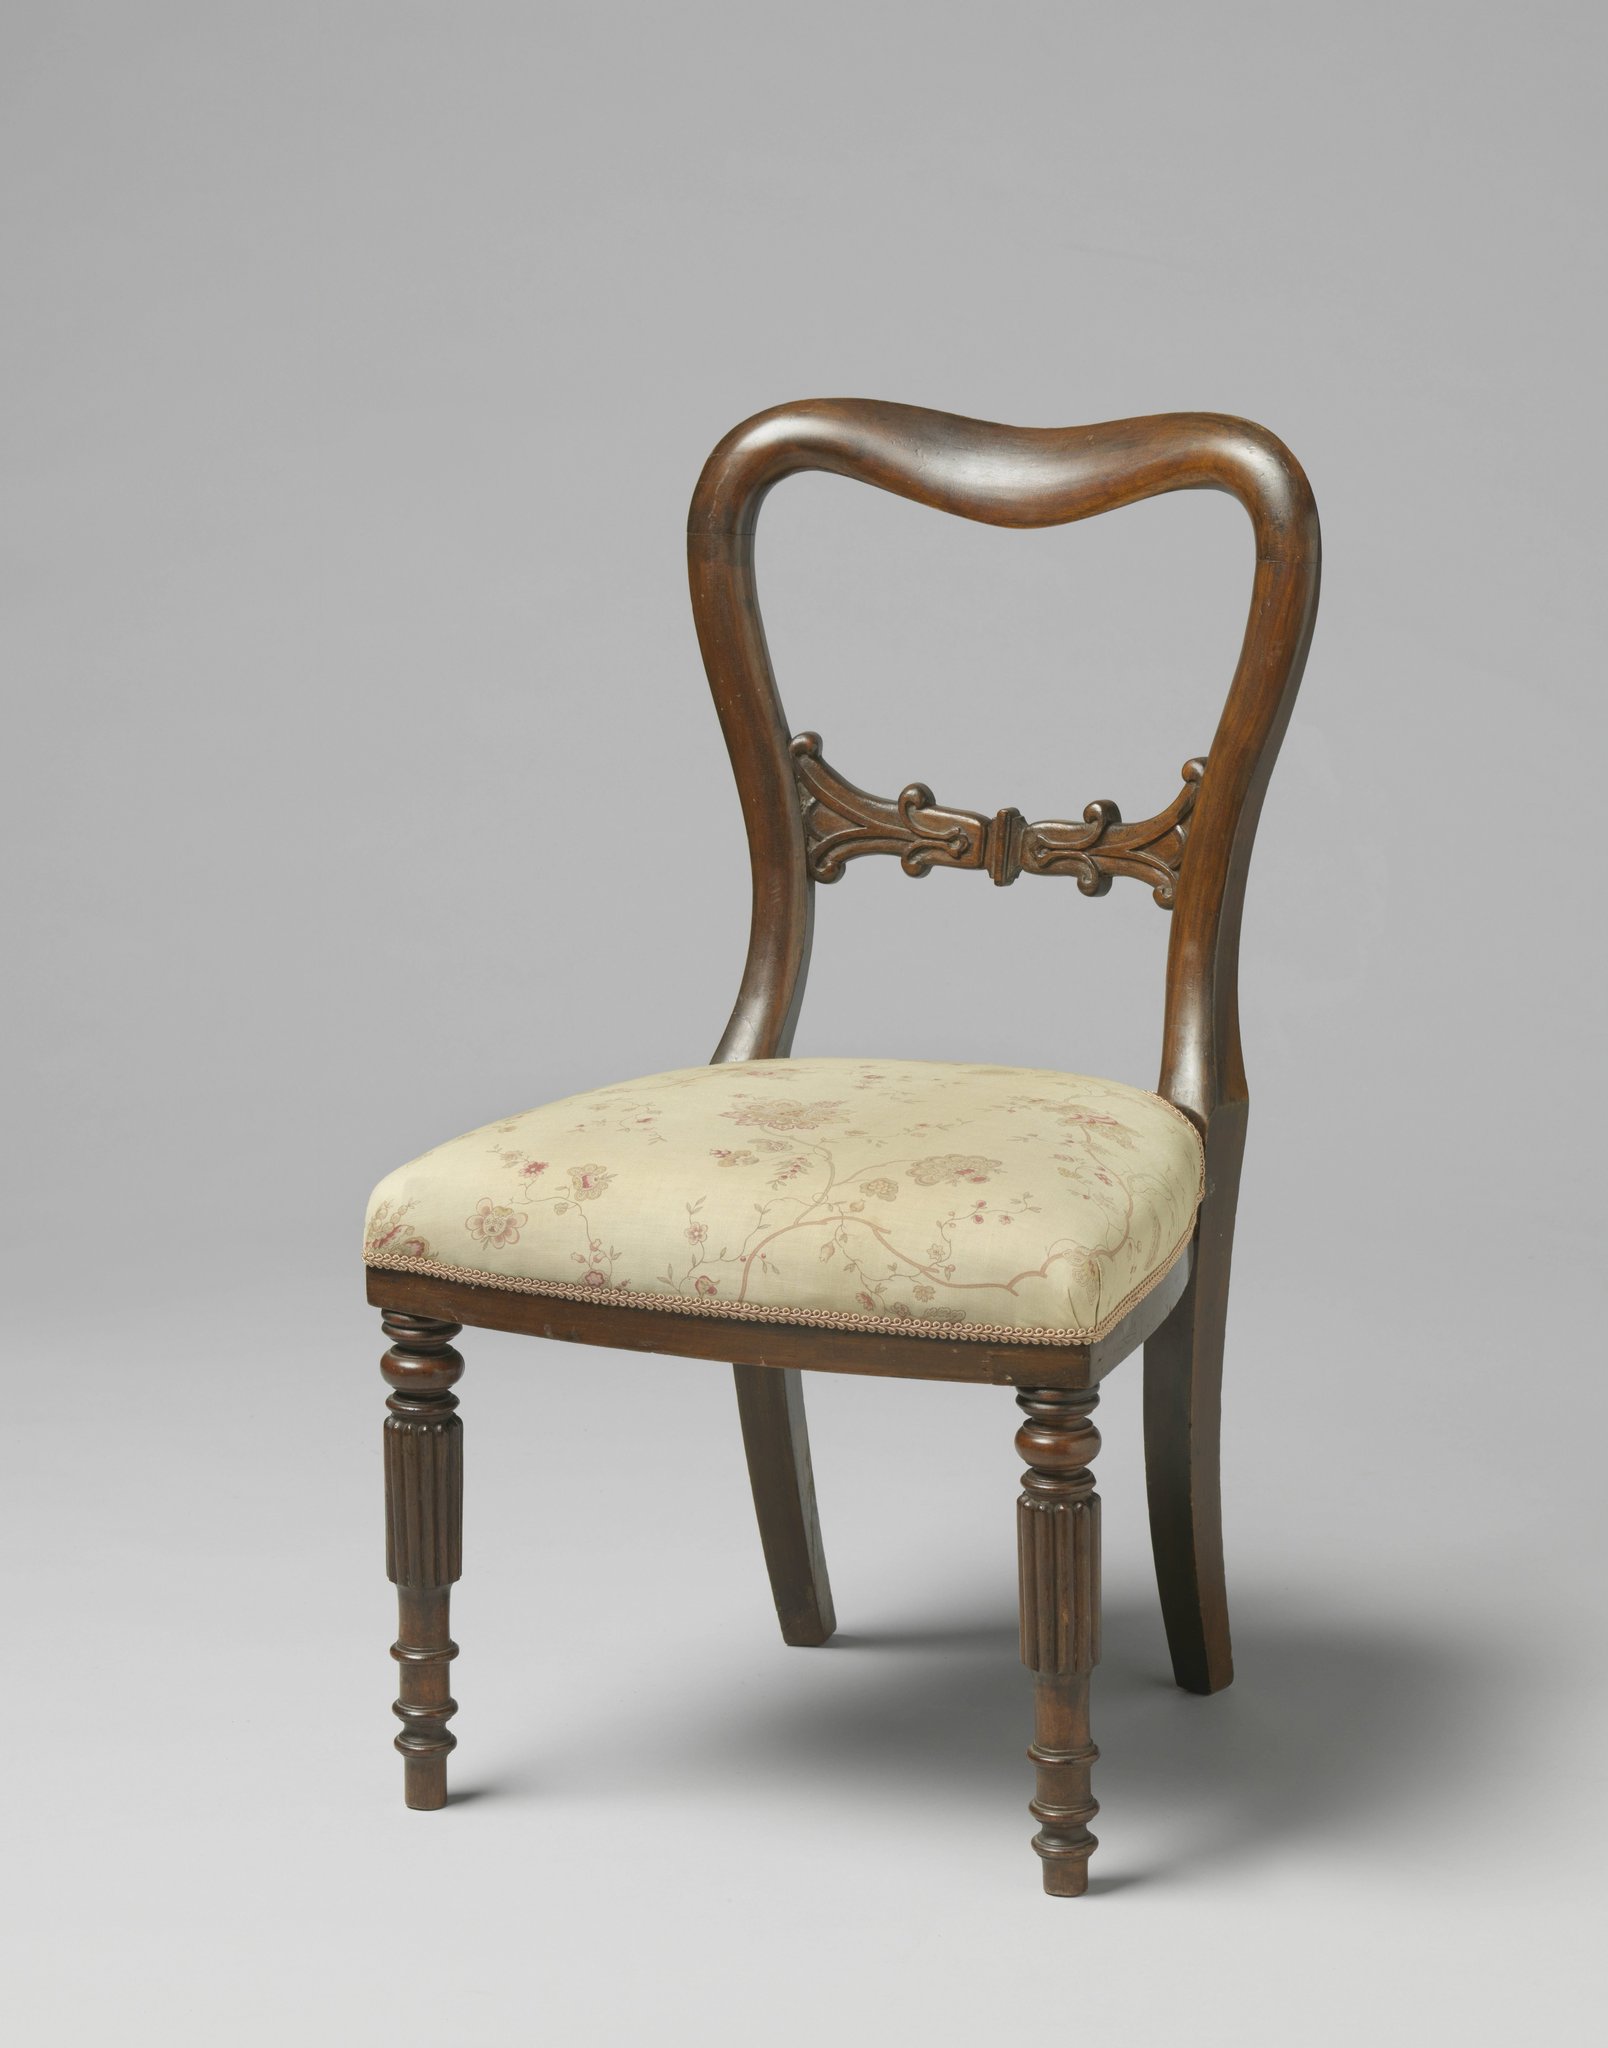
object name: armchair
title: Meubilair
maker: Anonymous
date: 1850-1875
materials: wood, textile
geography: northern netherlands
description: Stoel uit mahoniehouten kinderameublement bestaande uit drie stoelen en twee armstoelen. De ronde voorpoten zijn versierd met draaiwerk en met een rand van halfronde profielen. De sabelvormige achterpoten lopen over in het rugraam met gebogen stijlen en bovendorpel en met een tussenregel, versierd met symmetrisch geplaatste bladkelken, waartussen een verticaal geprofileerd sluitstuk. De S-vormige armleggers en stutten eindigen in een voluut; de onderzijde van de stutten dragen halfronde profielen. Beklede zitting.